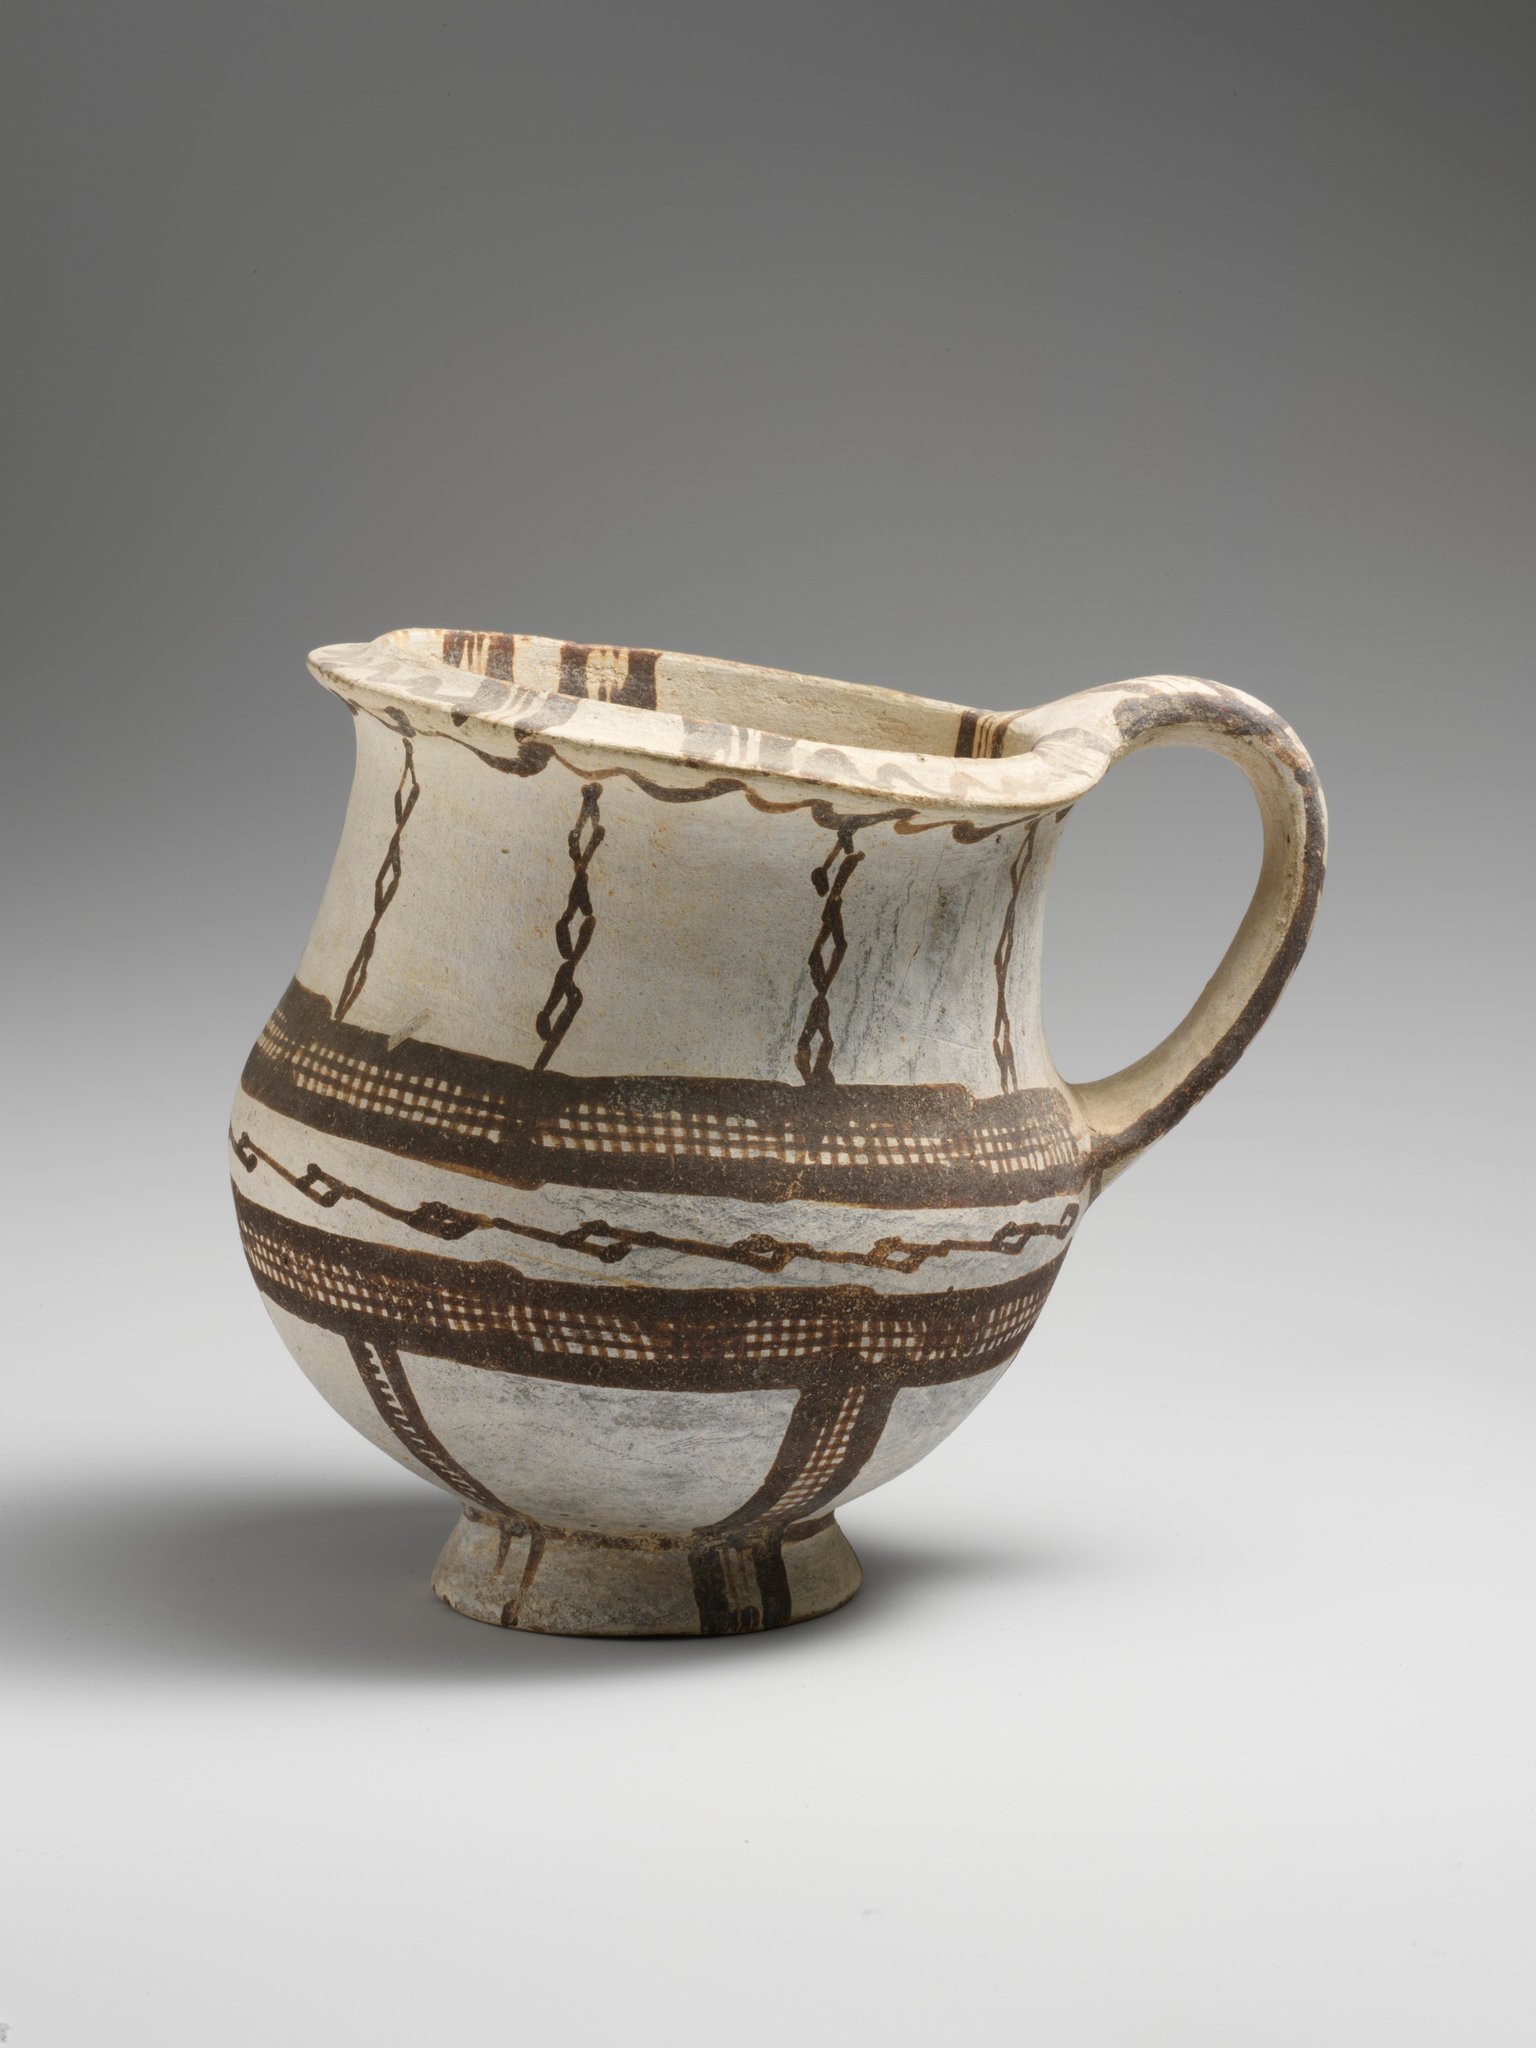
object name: tankard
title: Terracotta tankard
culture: cypriot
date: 1600-1150 BCE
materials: terracotta